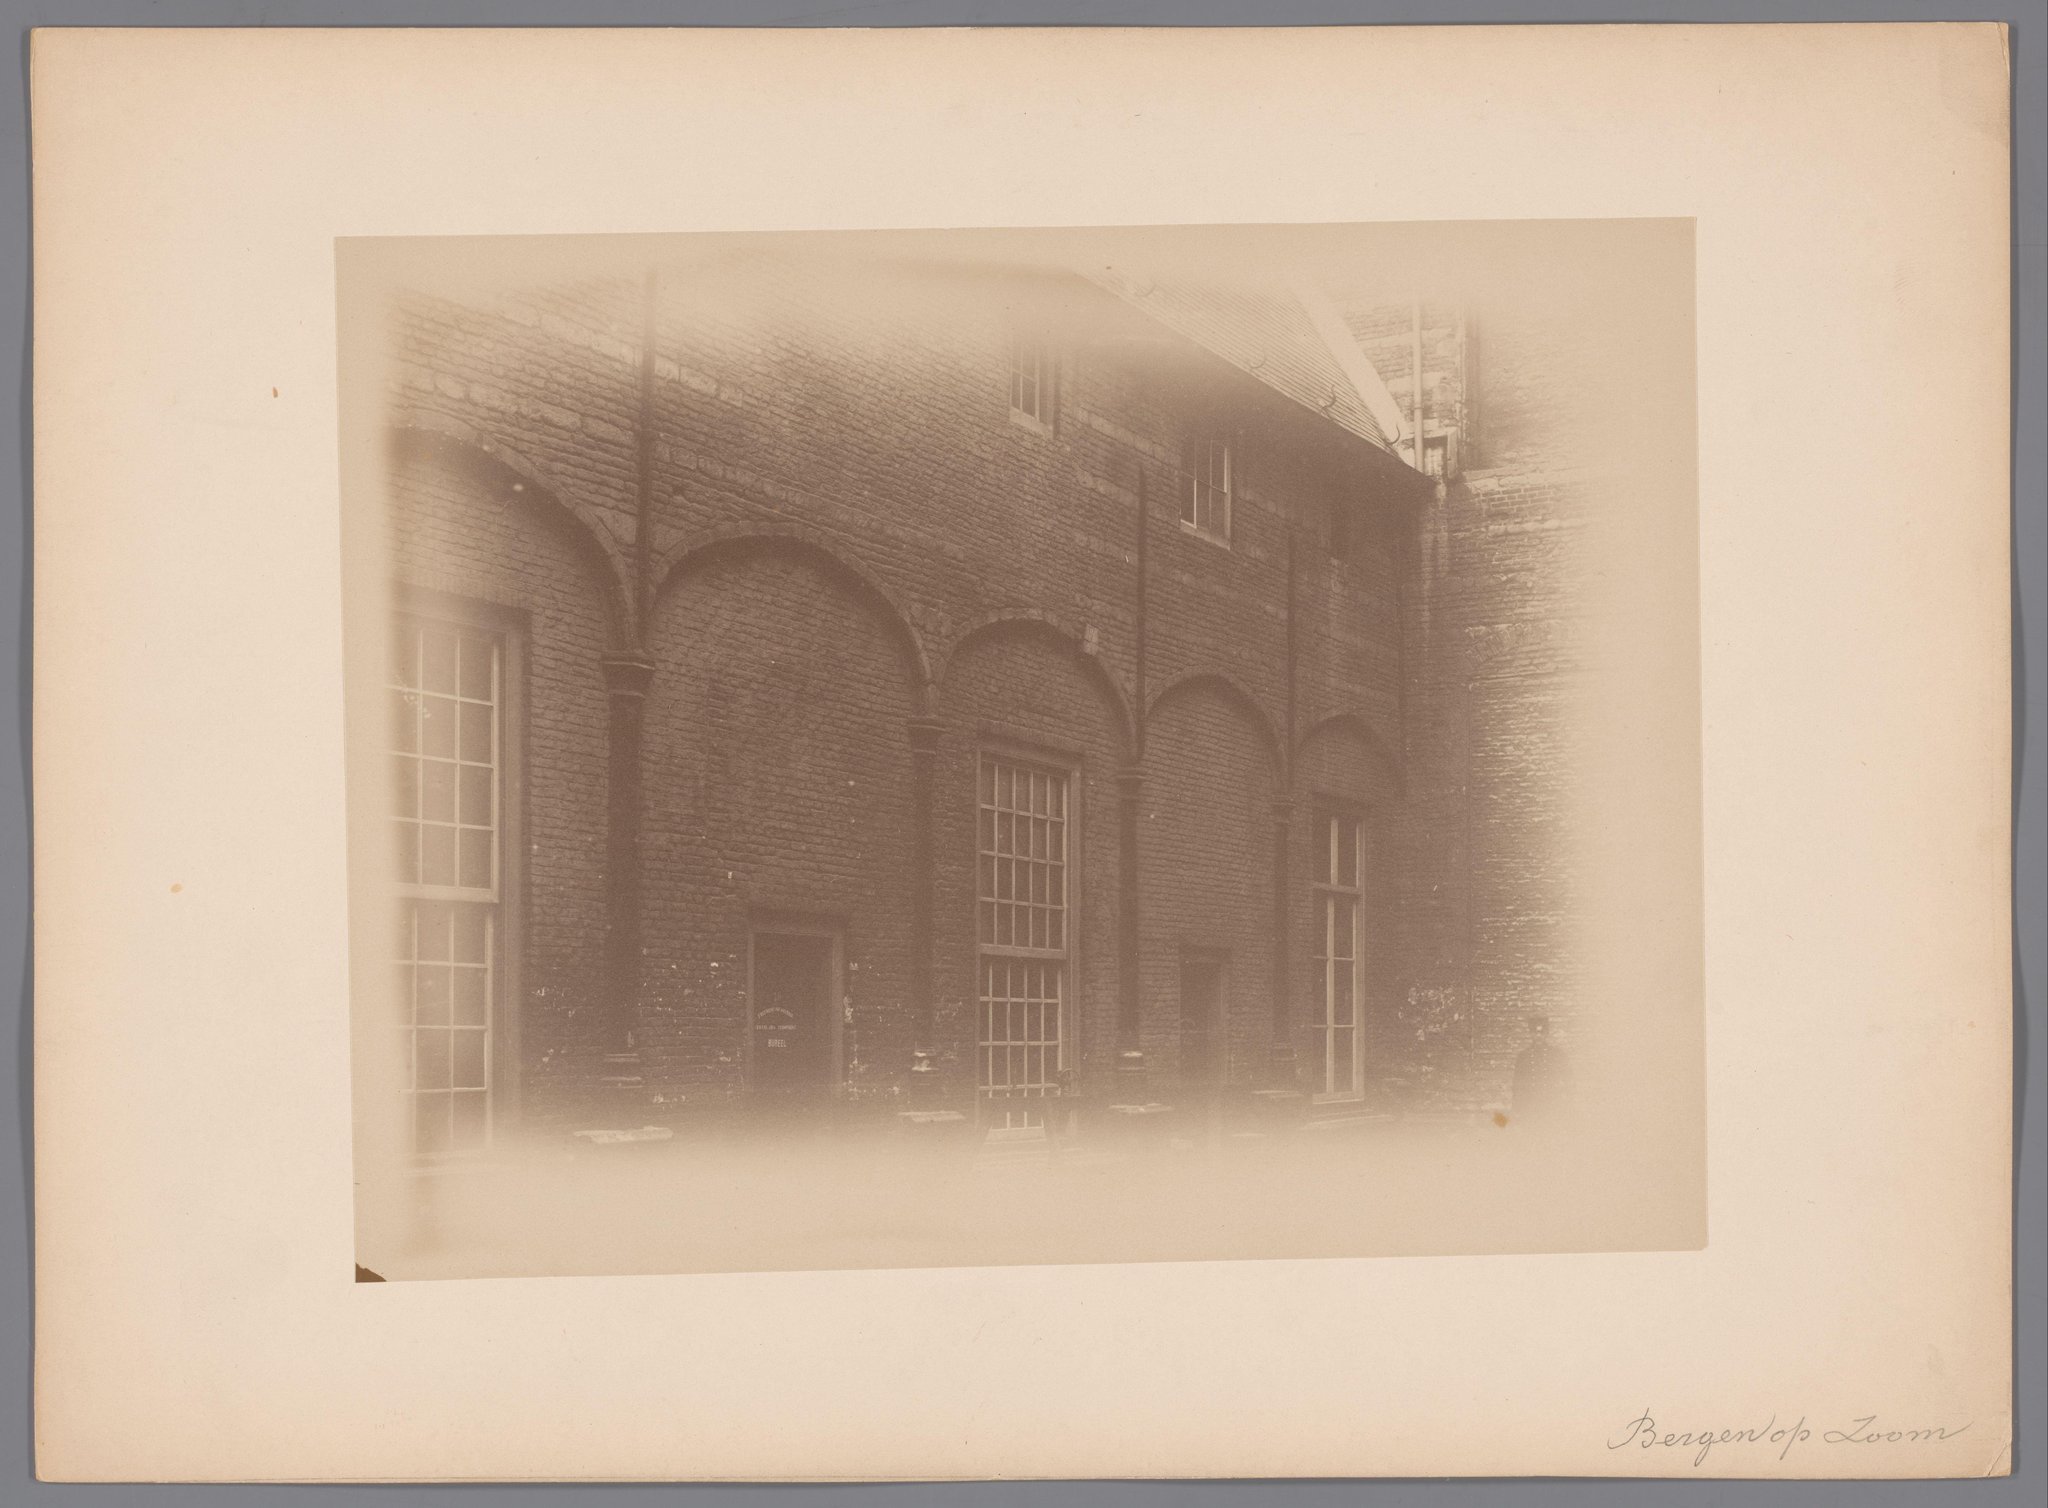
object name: photograph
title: Gevel aan de binnenplaats van het Markiezenhof te Bergen op Zoom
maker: anoniem (monumentenzorg)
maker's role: fotograaf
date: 1890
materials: cardboard, photographic support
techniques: albumen print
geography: markiezenhof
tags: courtyard, façade (of house or building)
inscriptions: annotation: ‘Bergen op Zoom’, annotation: ‘Markiezenhof te Bergen-op-Zoom/ Gevel op de kleine binnenplaats/ sept 1890’